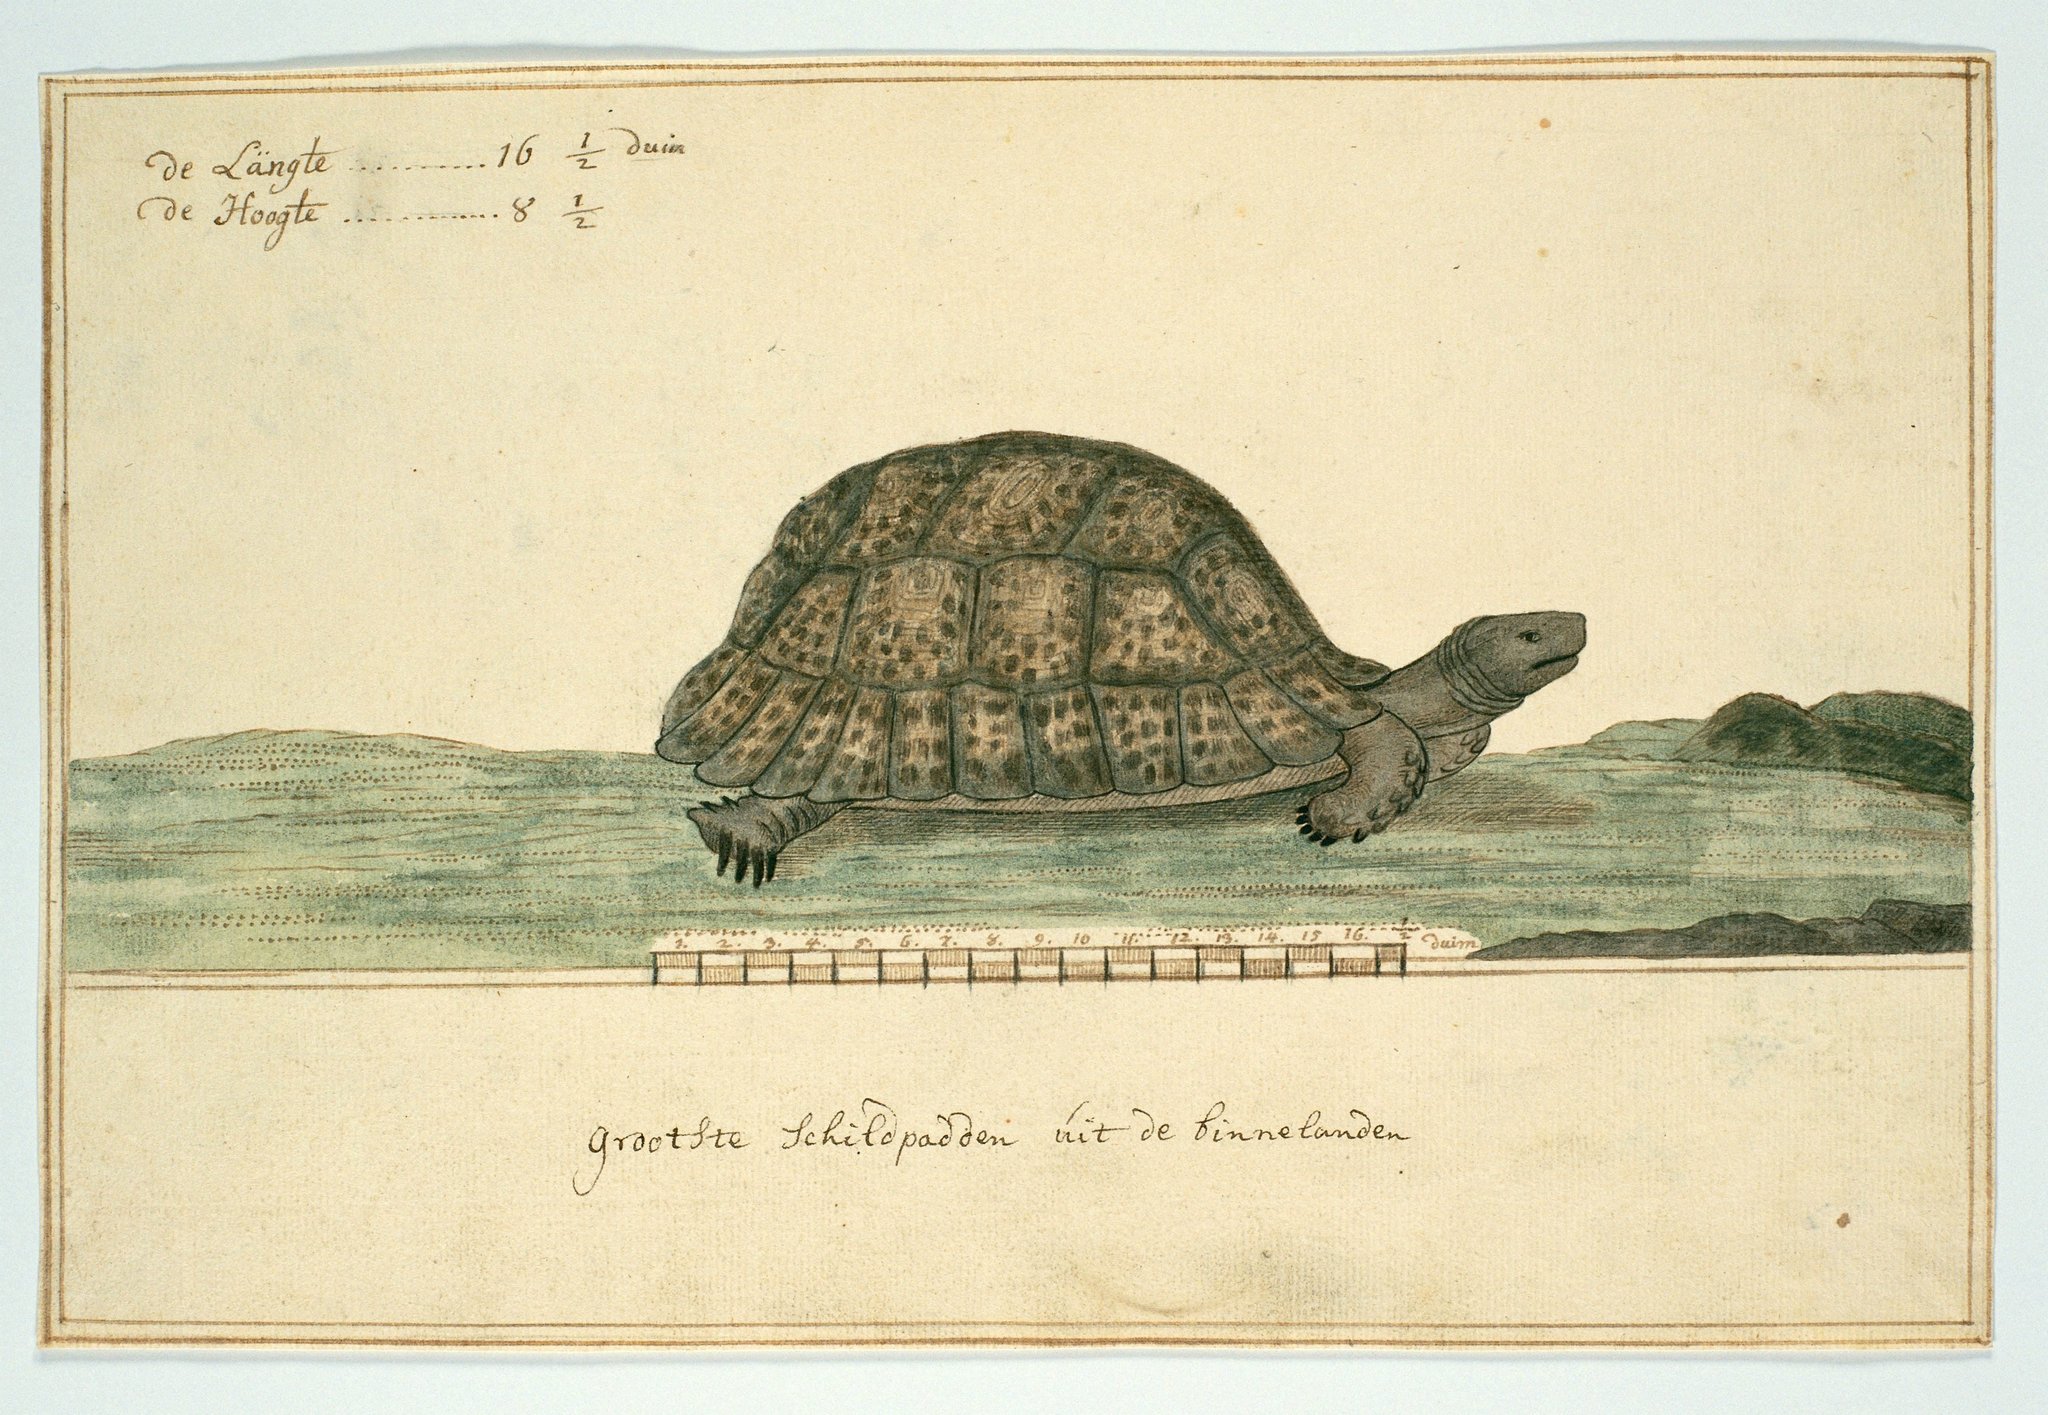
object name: drawing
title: Testudo pardalis (Leopard tortoise)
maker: robert jacob gordon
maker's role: draughtsman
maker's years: 1743-1795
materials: ink, paper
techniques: brush, pen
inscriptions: annotation: ‘l.b.: de Längte......16 ½ duim / de Hoogte.... 8 ½; m.o.: grootste Schildpadden uit de binnelanden’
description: Grote landschildpad (Testudo pardalis) uit de binnenlanden; met een schaalverdeling op de kaderlijnen onderaan de voorstelling en een lengte- en hoogtemaat linksboven.